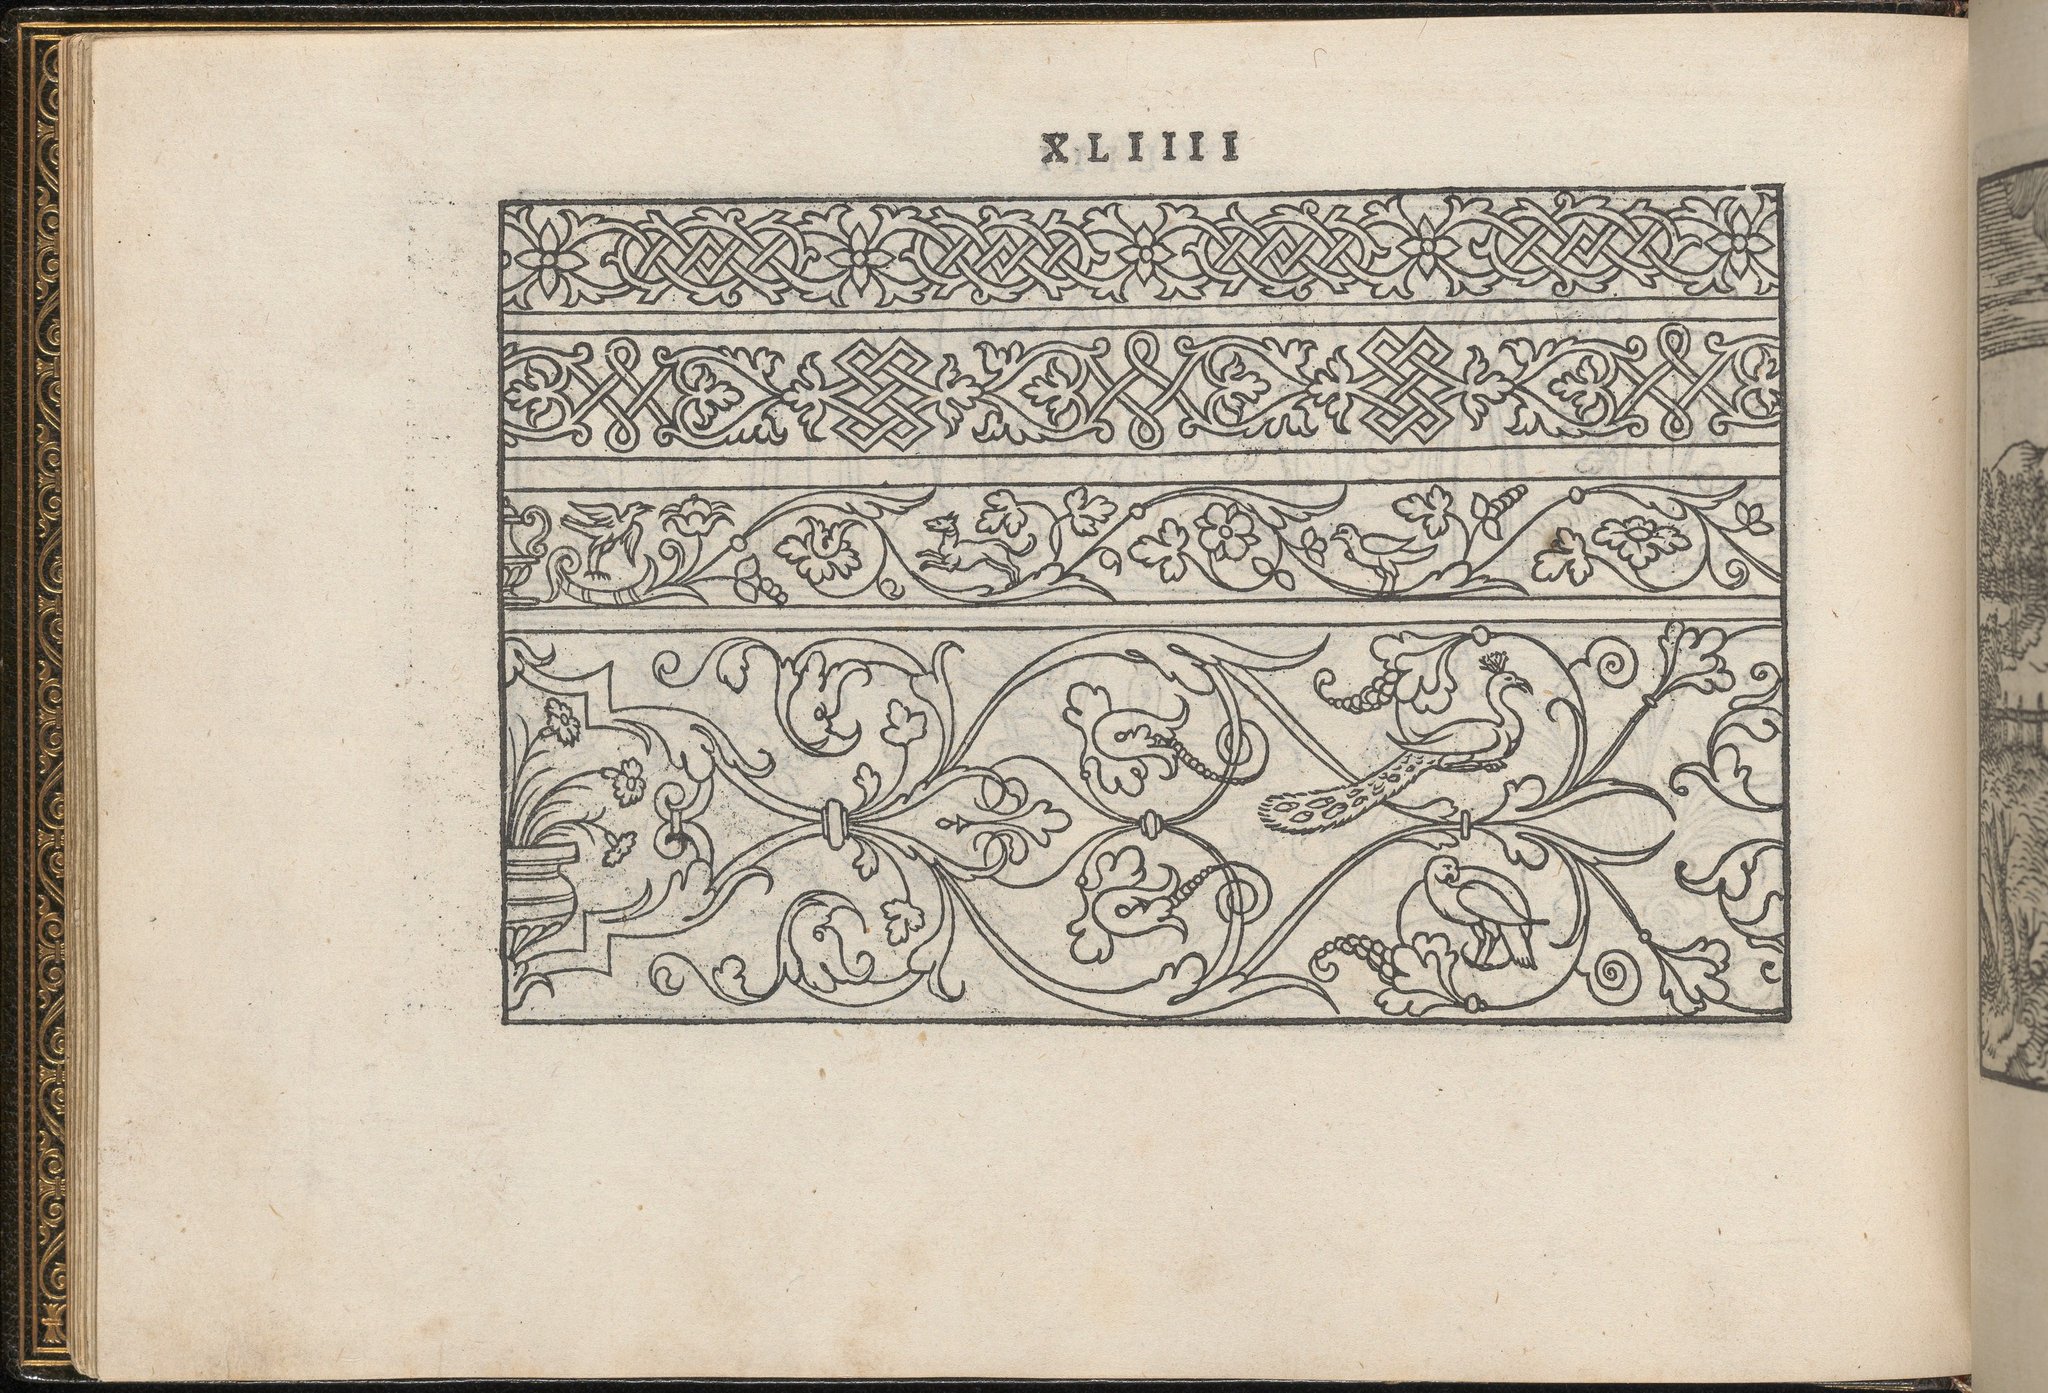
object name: book print ornament architecture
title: La Vera Perfettione del Disegno di varie sorti di recami, page 22 (verso)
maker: giovanni ostaus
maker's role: publisher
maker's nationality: italian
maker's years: 1507-1607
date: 1567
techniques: woodcut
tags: birds,peacocks,dogs,flowers,vines